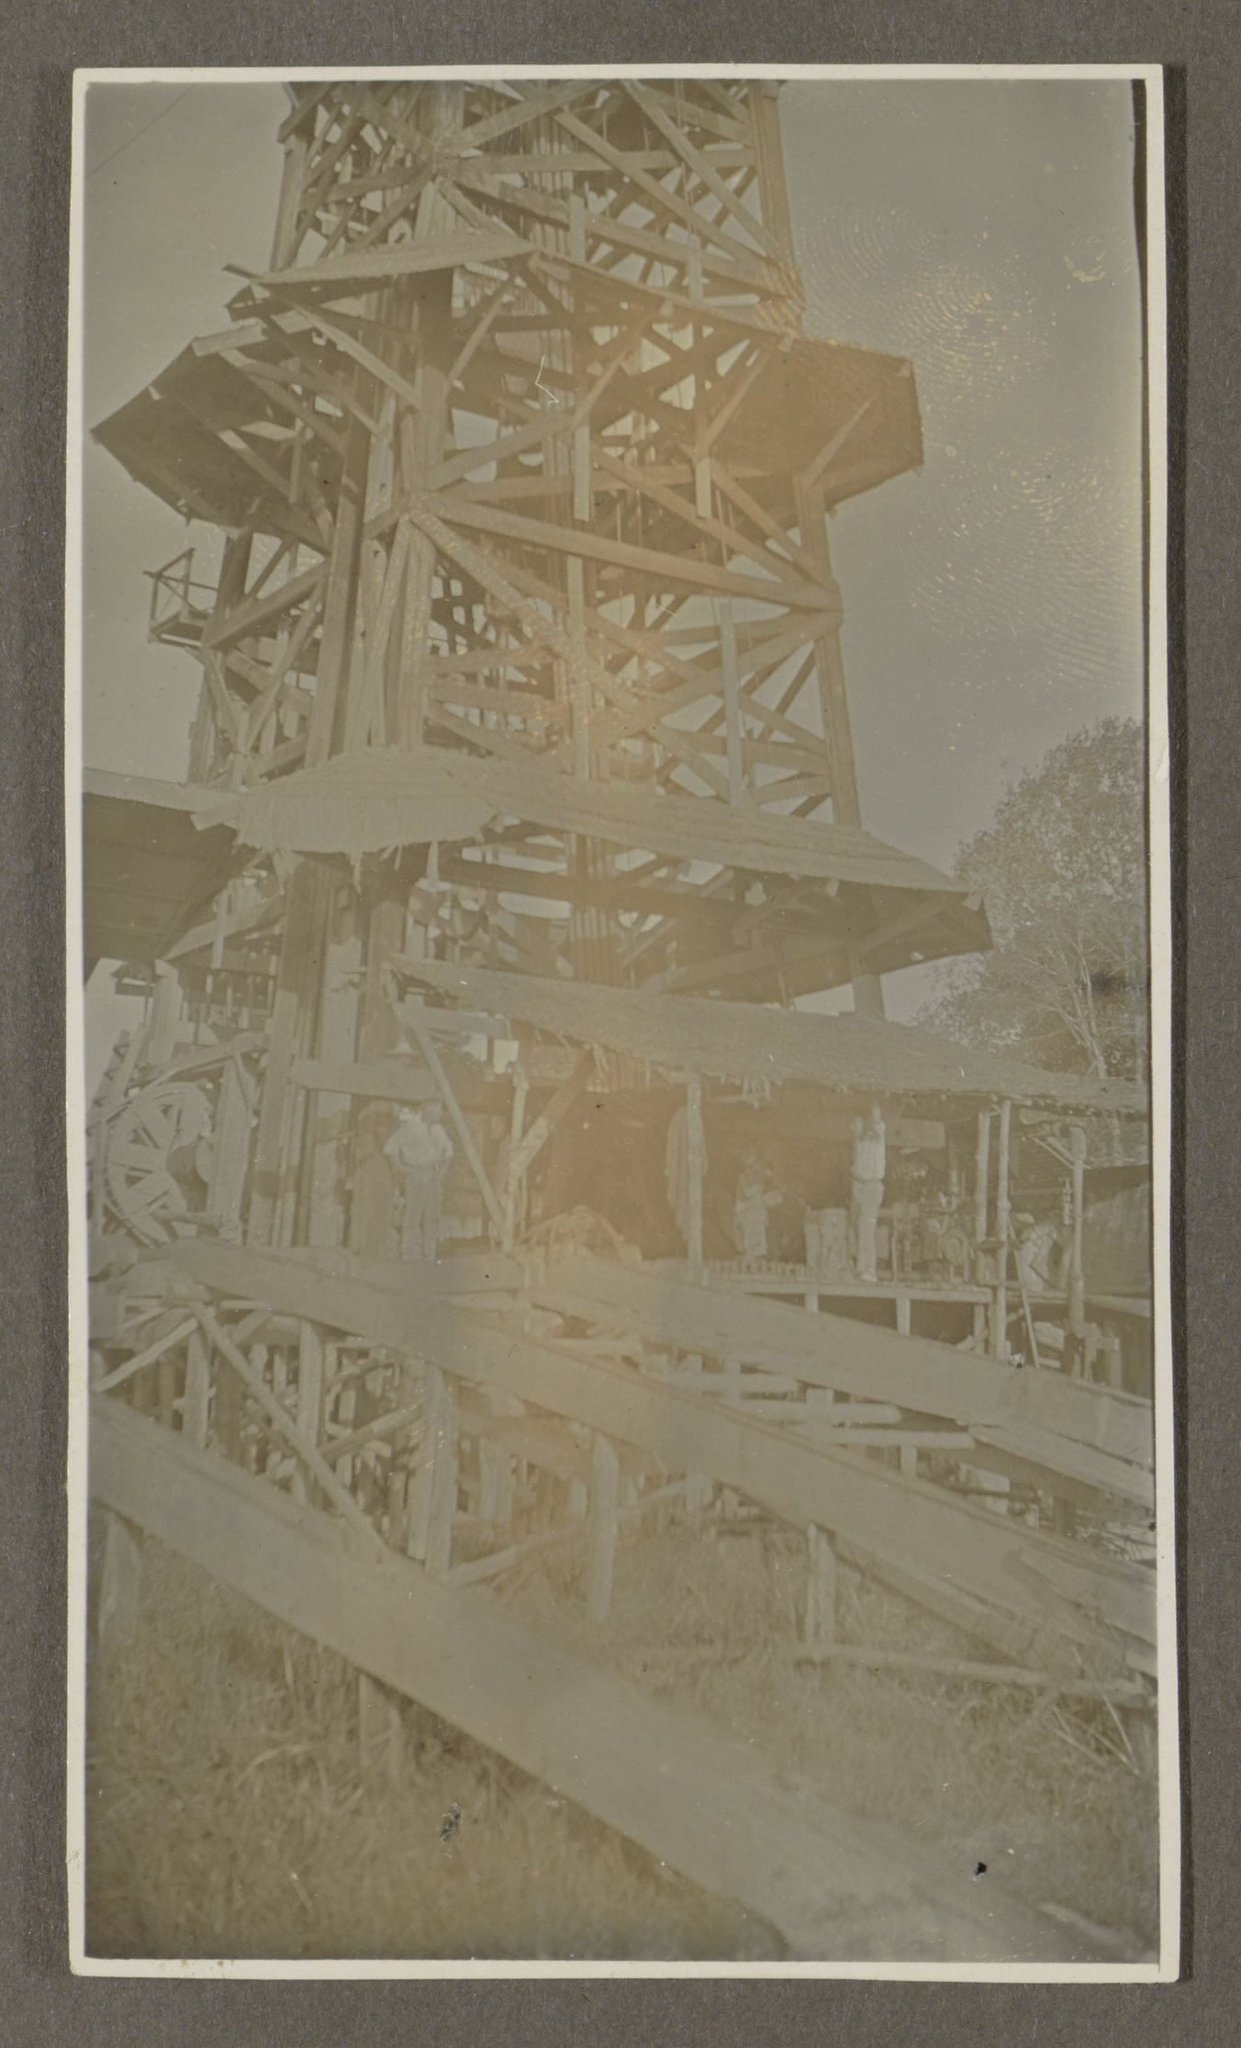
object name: photograph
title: Boortoren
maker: Anonymous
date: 1920-1930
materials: photographic support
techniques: gelatin silver print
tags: derrick ~ oil, dutch east indies, the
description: Onderdeel van familiealbum Nederlands-Indië.